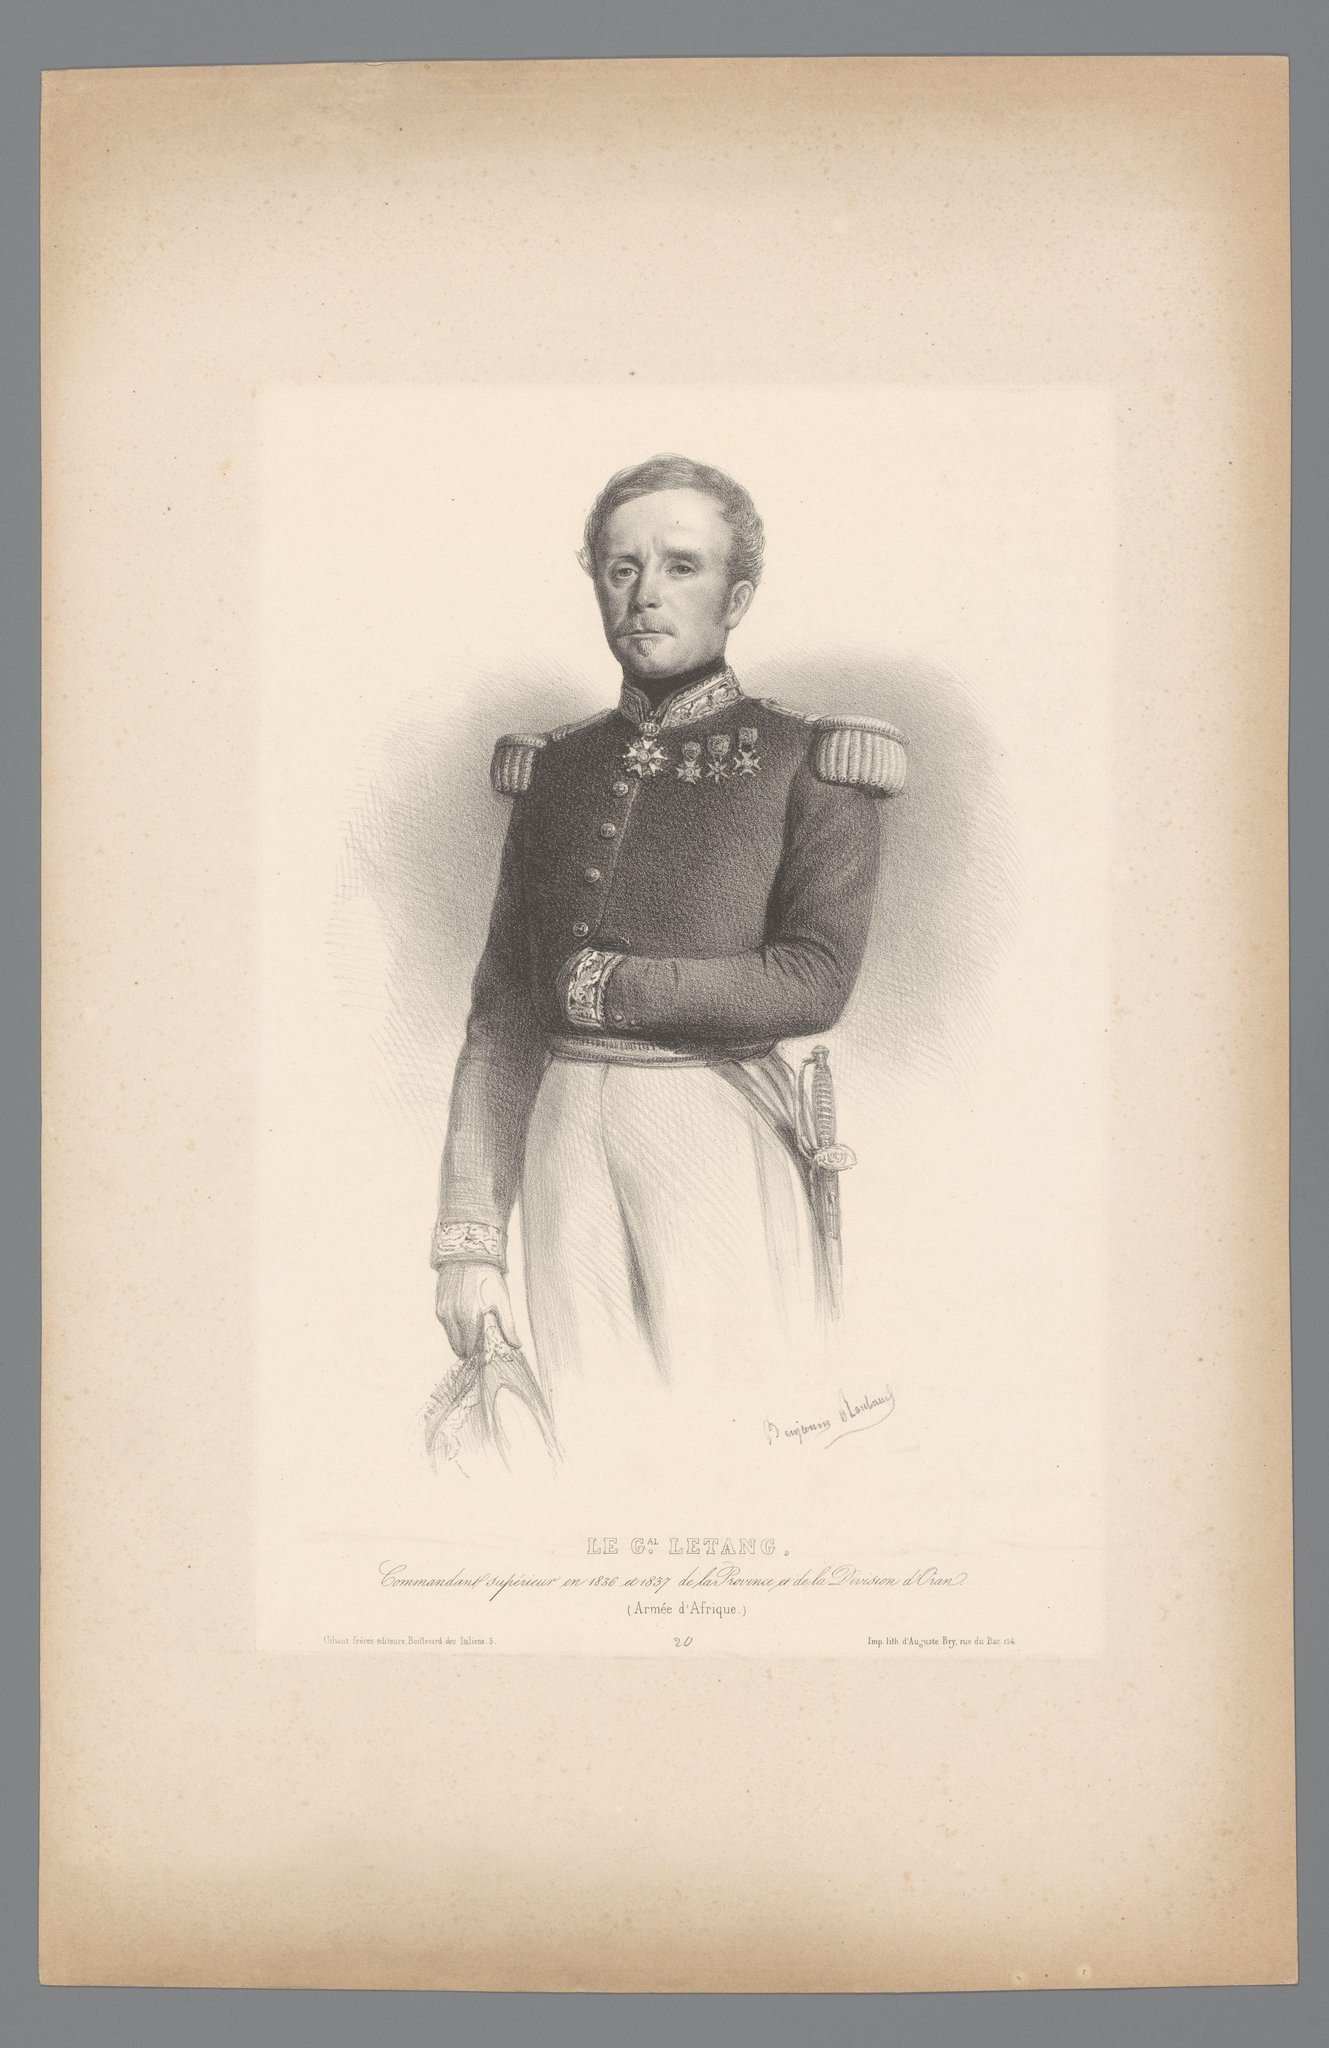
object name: print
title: Le gal. Letang, commandant supérieur en 1836 et 1837 de la province et de la division d'Oran. (Armée d'Afrique.)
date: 1843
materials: paper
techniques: lithograph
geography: paris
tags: commander-in-chief, general, marshal, historical persons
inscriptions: collector's mark: Lugt 2228